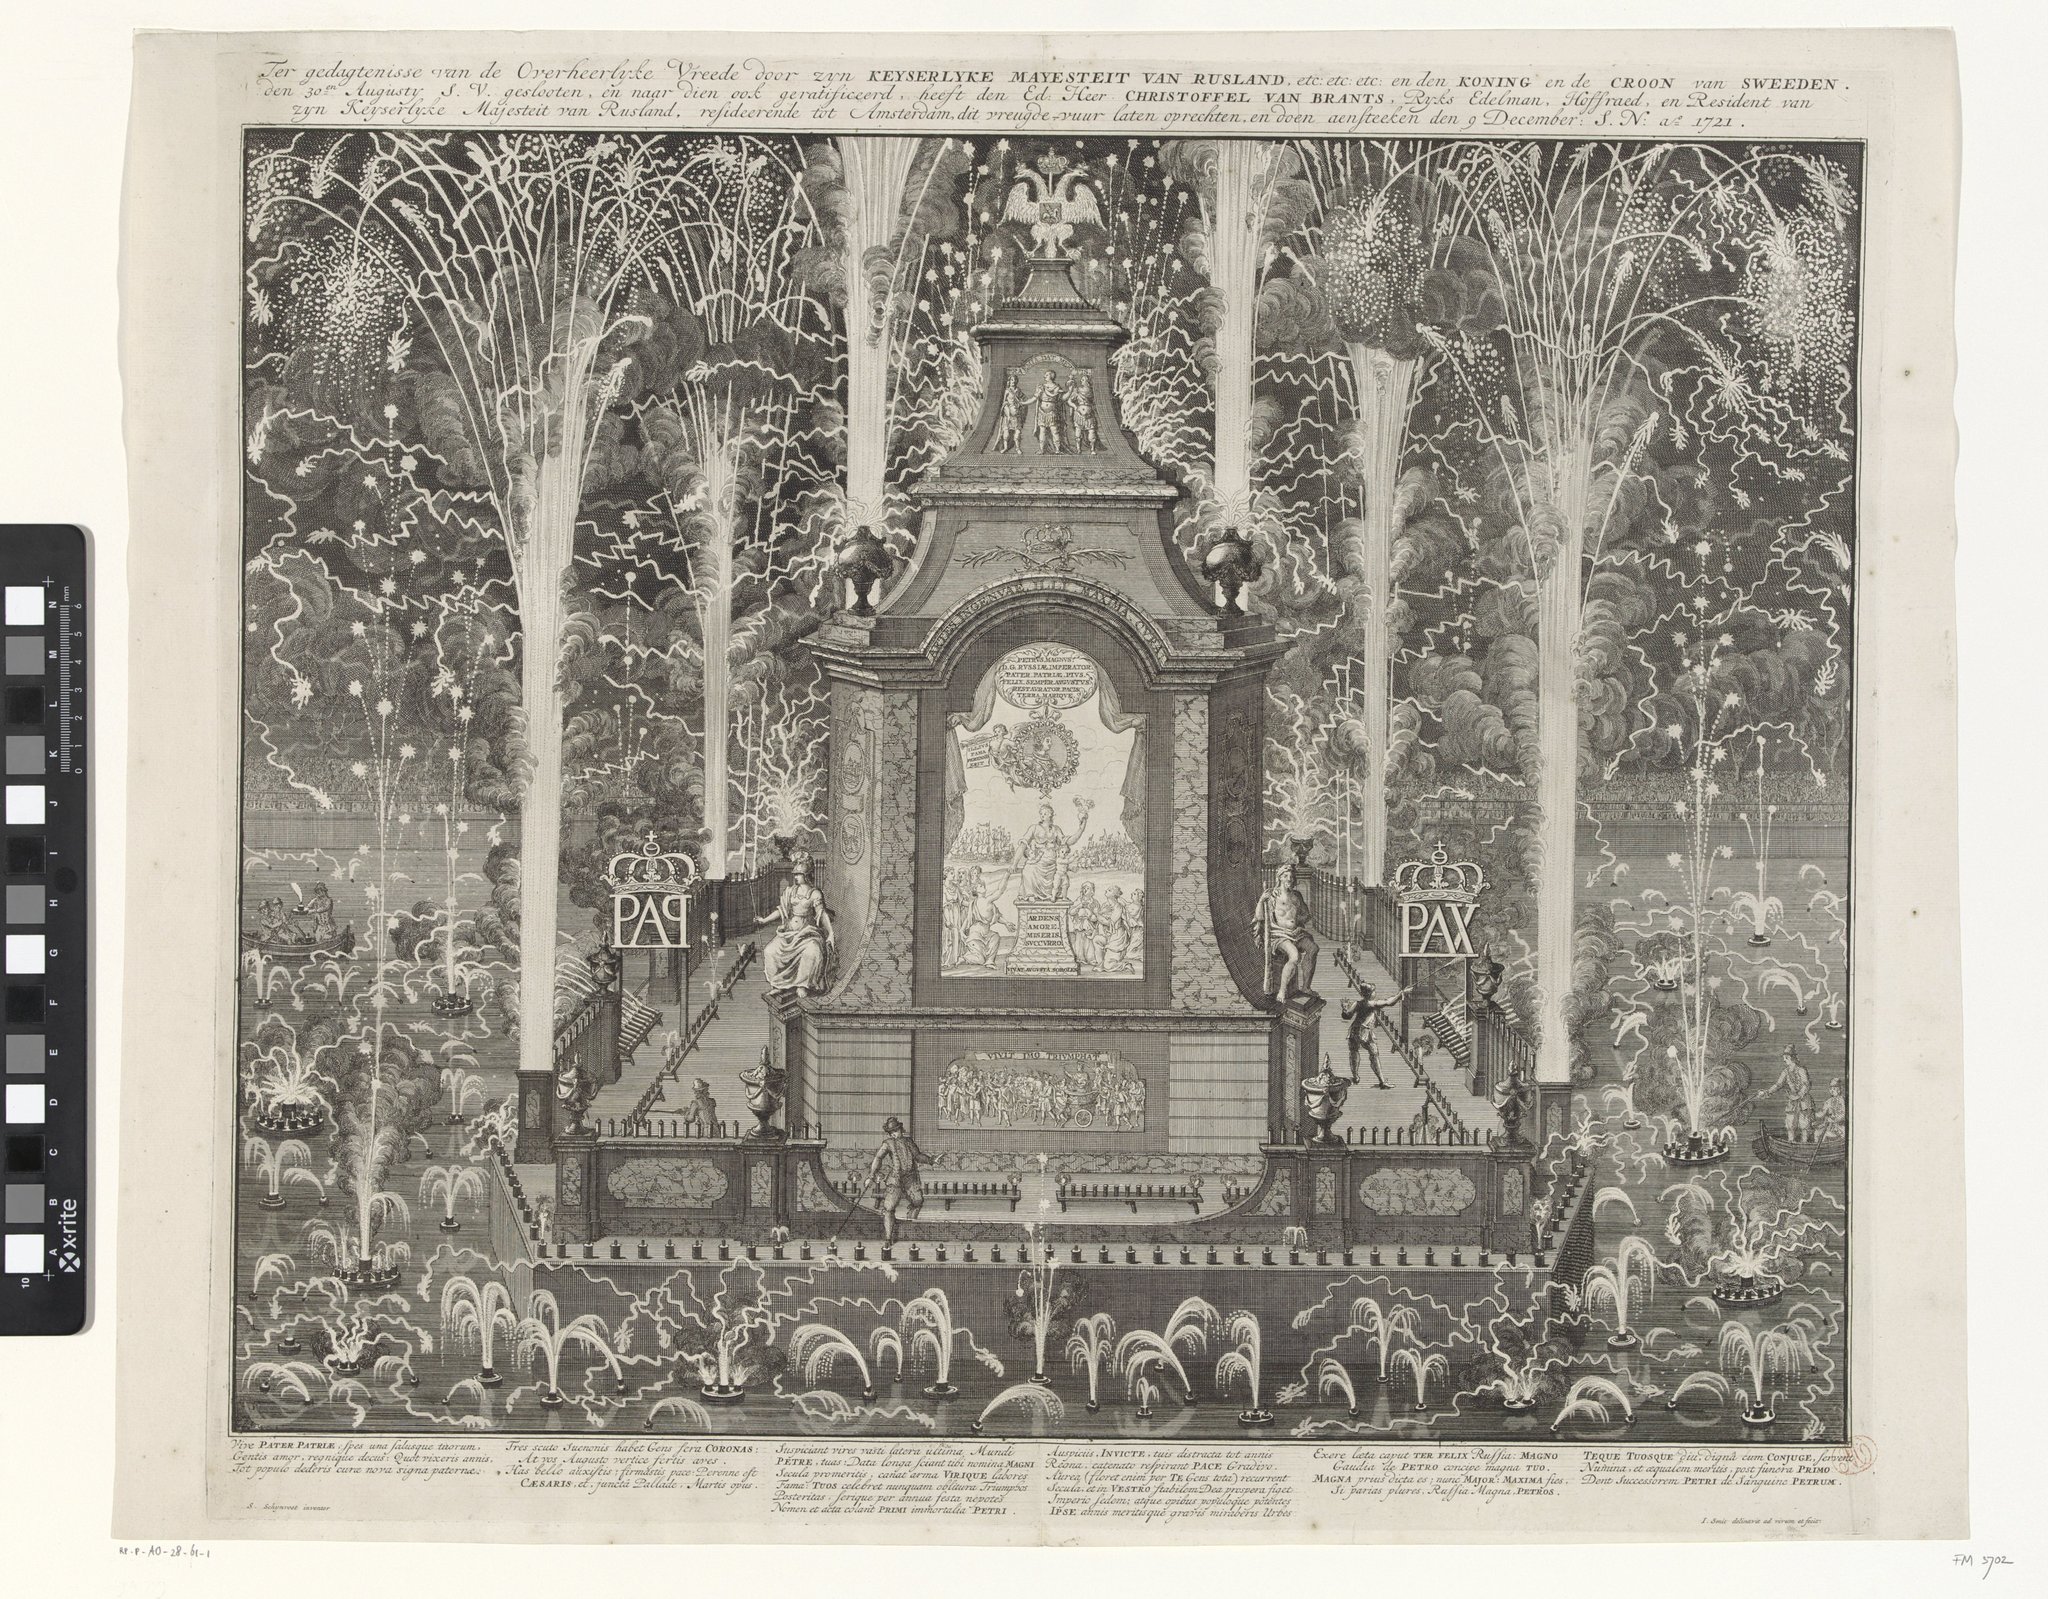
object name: print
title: Vuurwerk ter viering van de Vrede van Nystad op de Binnen-Amstel te Amsterdam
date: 1721-1723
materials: paper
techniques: etching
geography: amsterdam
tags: amsterdam, christoffel van brants, bonfire, fire-works (+ illumination, fire-works ~ festive activities)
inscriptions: collector's mark: Lugt Lugt 2228, collector's mark: Lugt 195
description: Vuurwerk afgestoken vanaf de Tempel der Vrede op 9 december 1721 op de Binnen-Amstel bij de Kloveniersburgwal ter viering van de Vrede van Nystad gesloten tussen Rusland en Zweden op 10 september 1721. Het vuurwerk in opdracht van Christoffel van Brants, vertegenwoordiger van de Russische kroon te Amsterdam. Met onderschrift in het Latijn in zes kolommen.